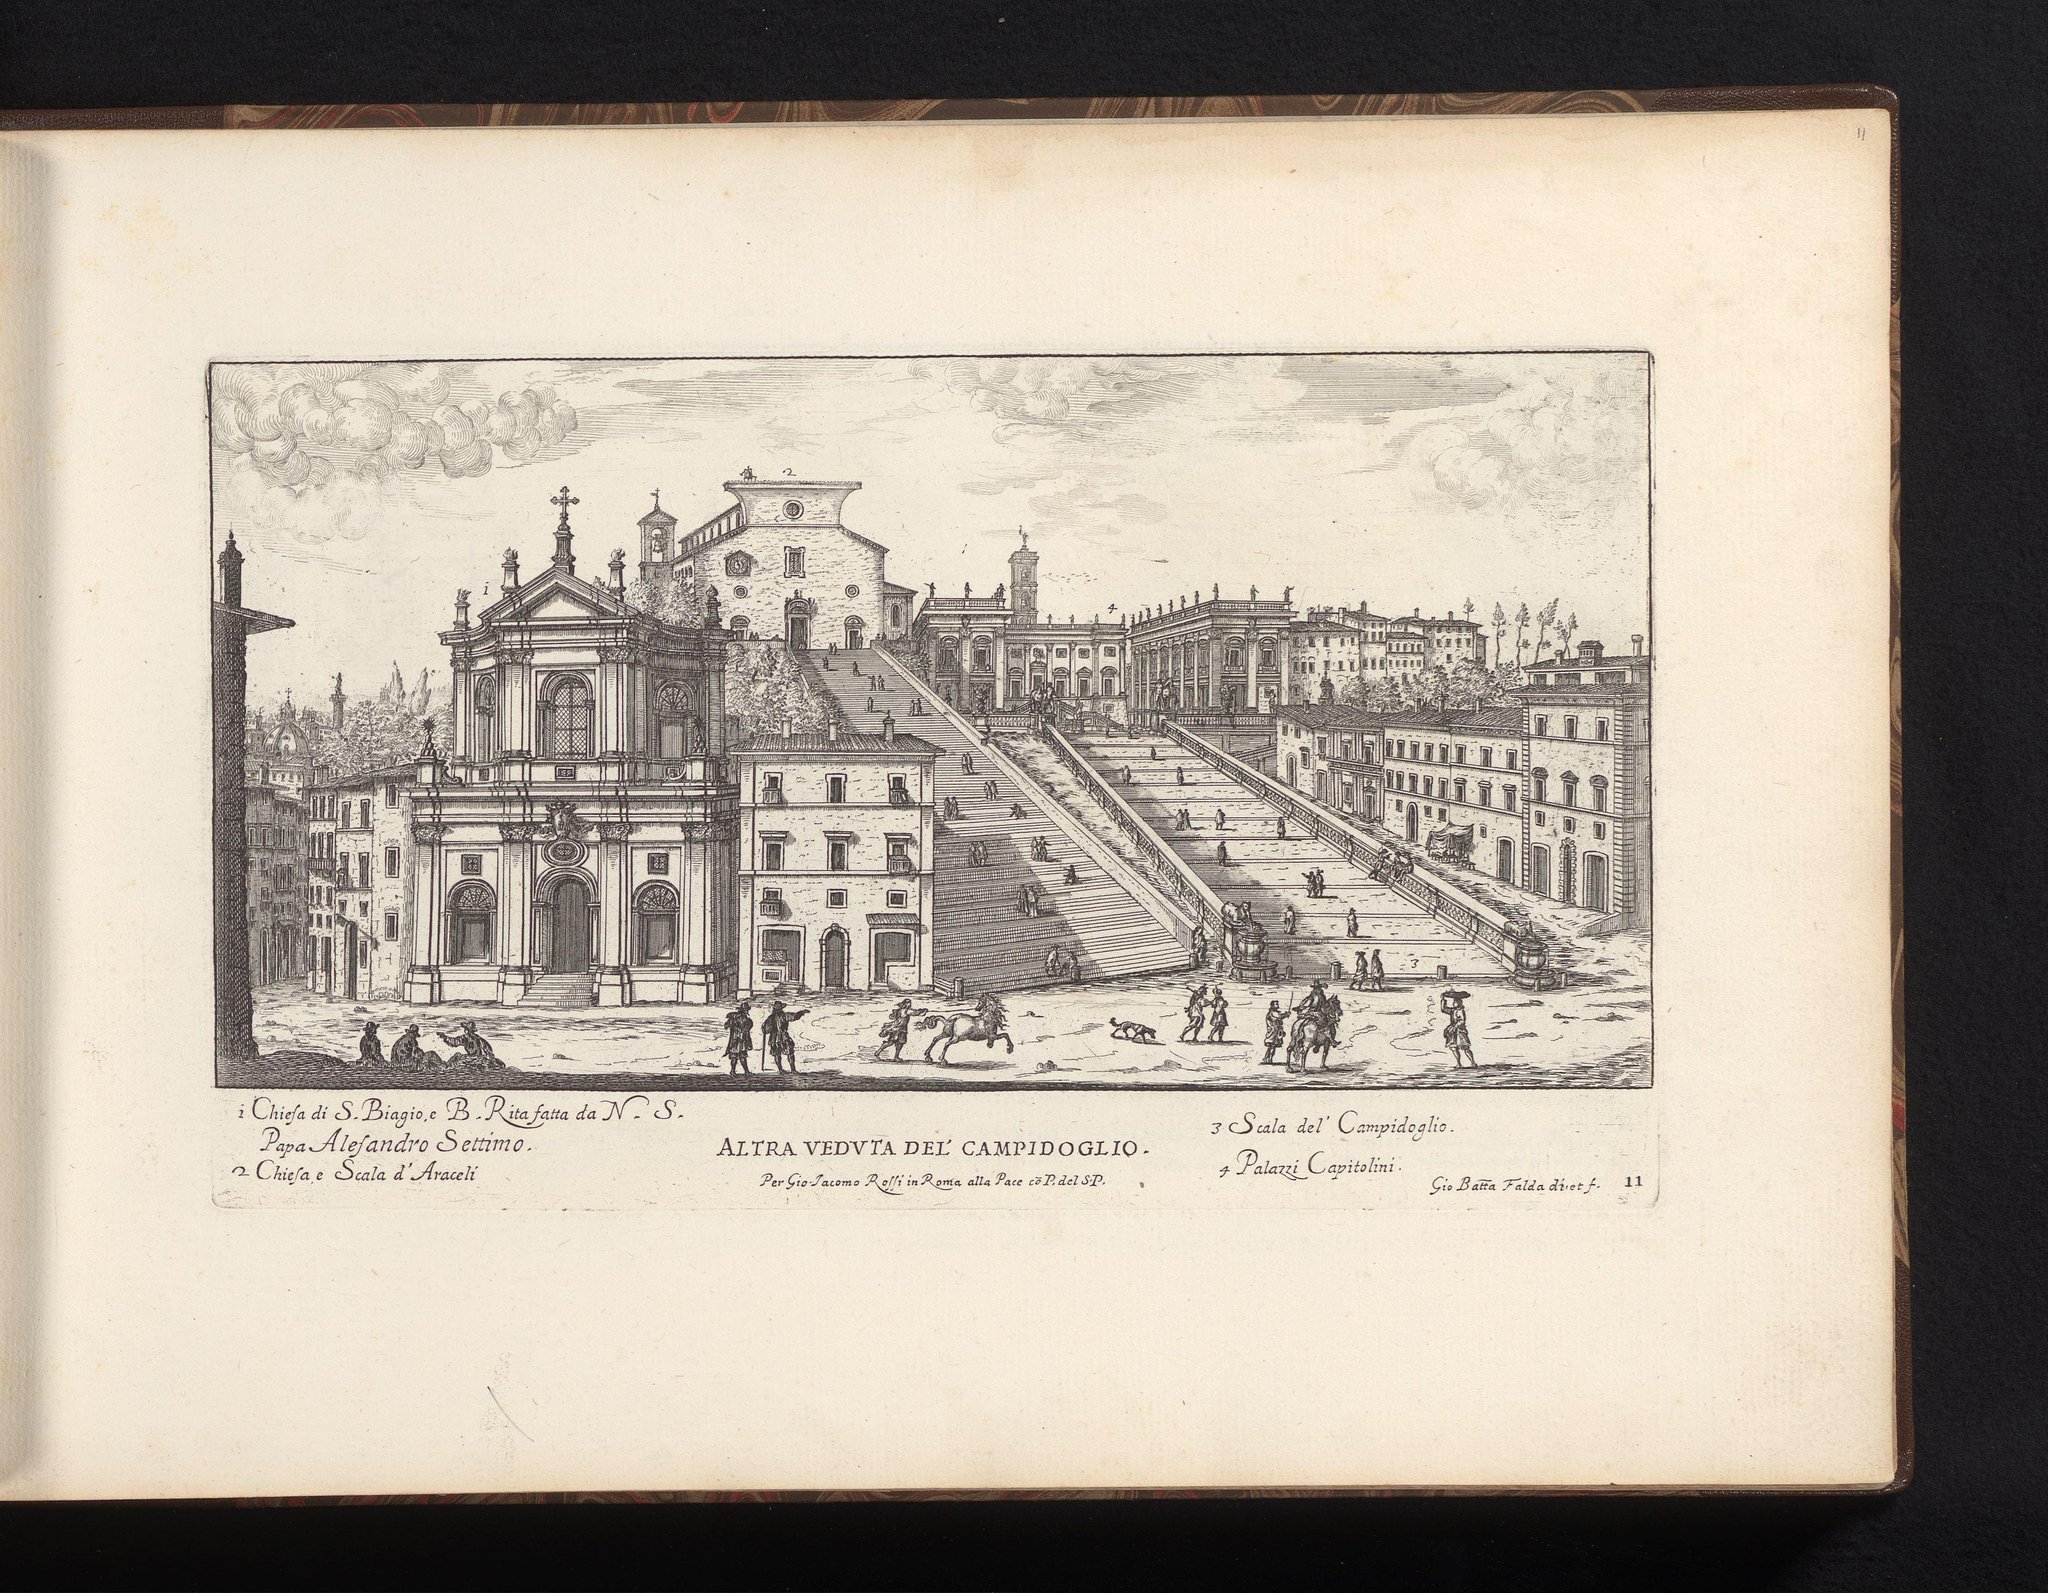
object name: album leaf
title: Il nuovo teatro di Roma moderna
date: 1665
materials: paper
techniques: etching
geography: vatican city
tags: square, place, circus, etc., city-view, and landscape with man-made constructions, church (exterior), representation of real building (either existing or having existed)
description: Gezicht op de Capitool-heuvel met links de Santa Maria in Aracoeli en op de voorgrond links de Chiesa di Santa Rita da Cascia in Campitelli. Deze laatste kerk in werkelijkheid op enige afstand van het Capitool. Titel en een verklarende lijst met nummers in de ondermarge. Prent maakt deel uit van een album.